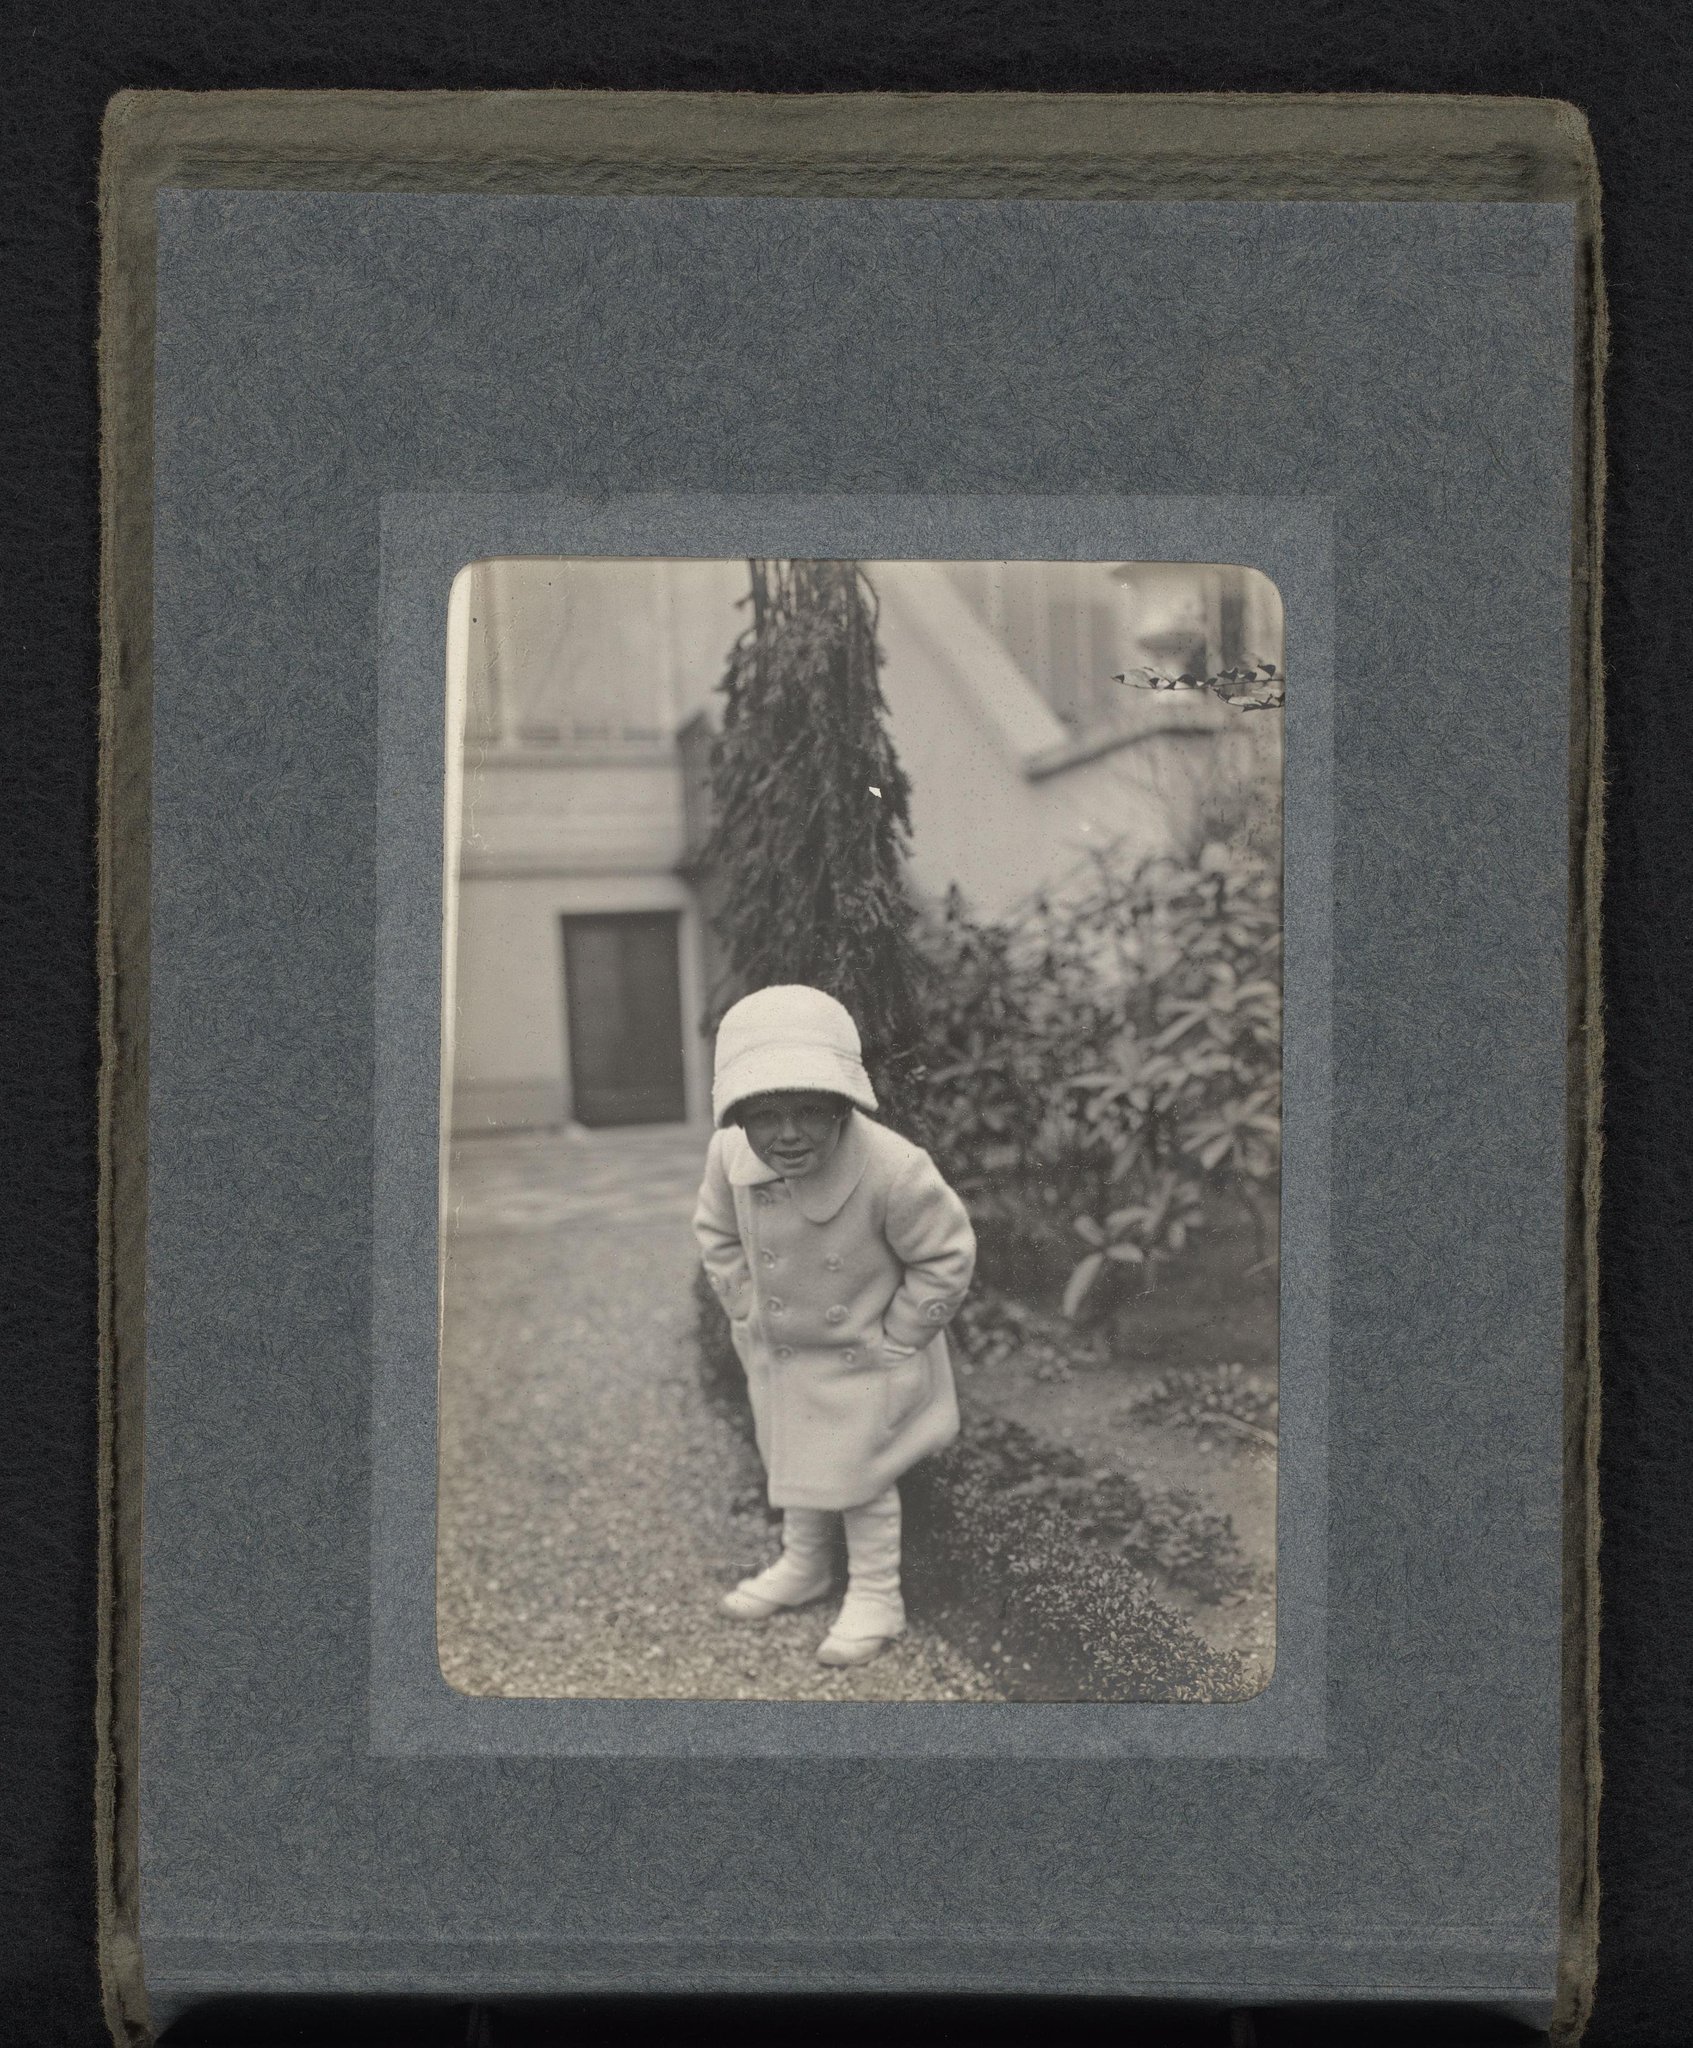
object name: album leaf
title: Portret van Cay van den Berg in de tuin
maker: hendrik herman van den berg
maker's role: amateurfotograaf, jurist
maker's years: 1875-1944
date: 1912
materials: paper, cardboard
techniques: gelatin silver print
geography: amsterdam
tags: carel frederik van den berg (cay), toddler, garden, historical persons